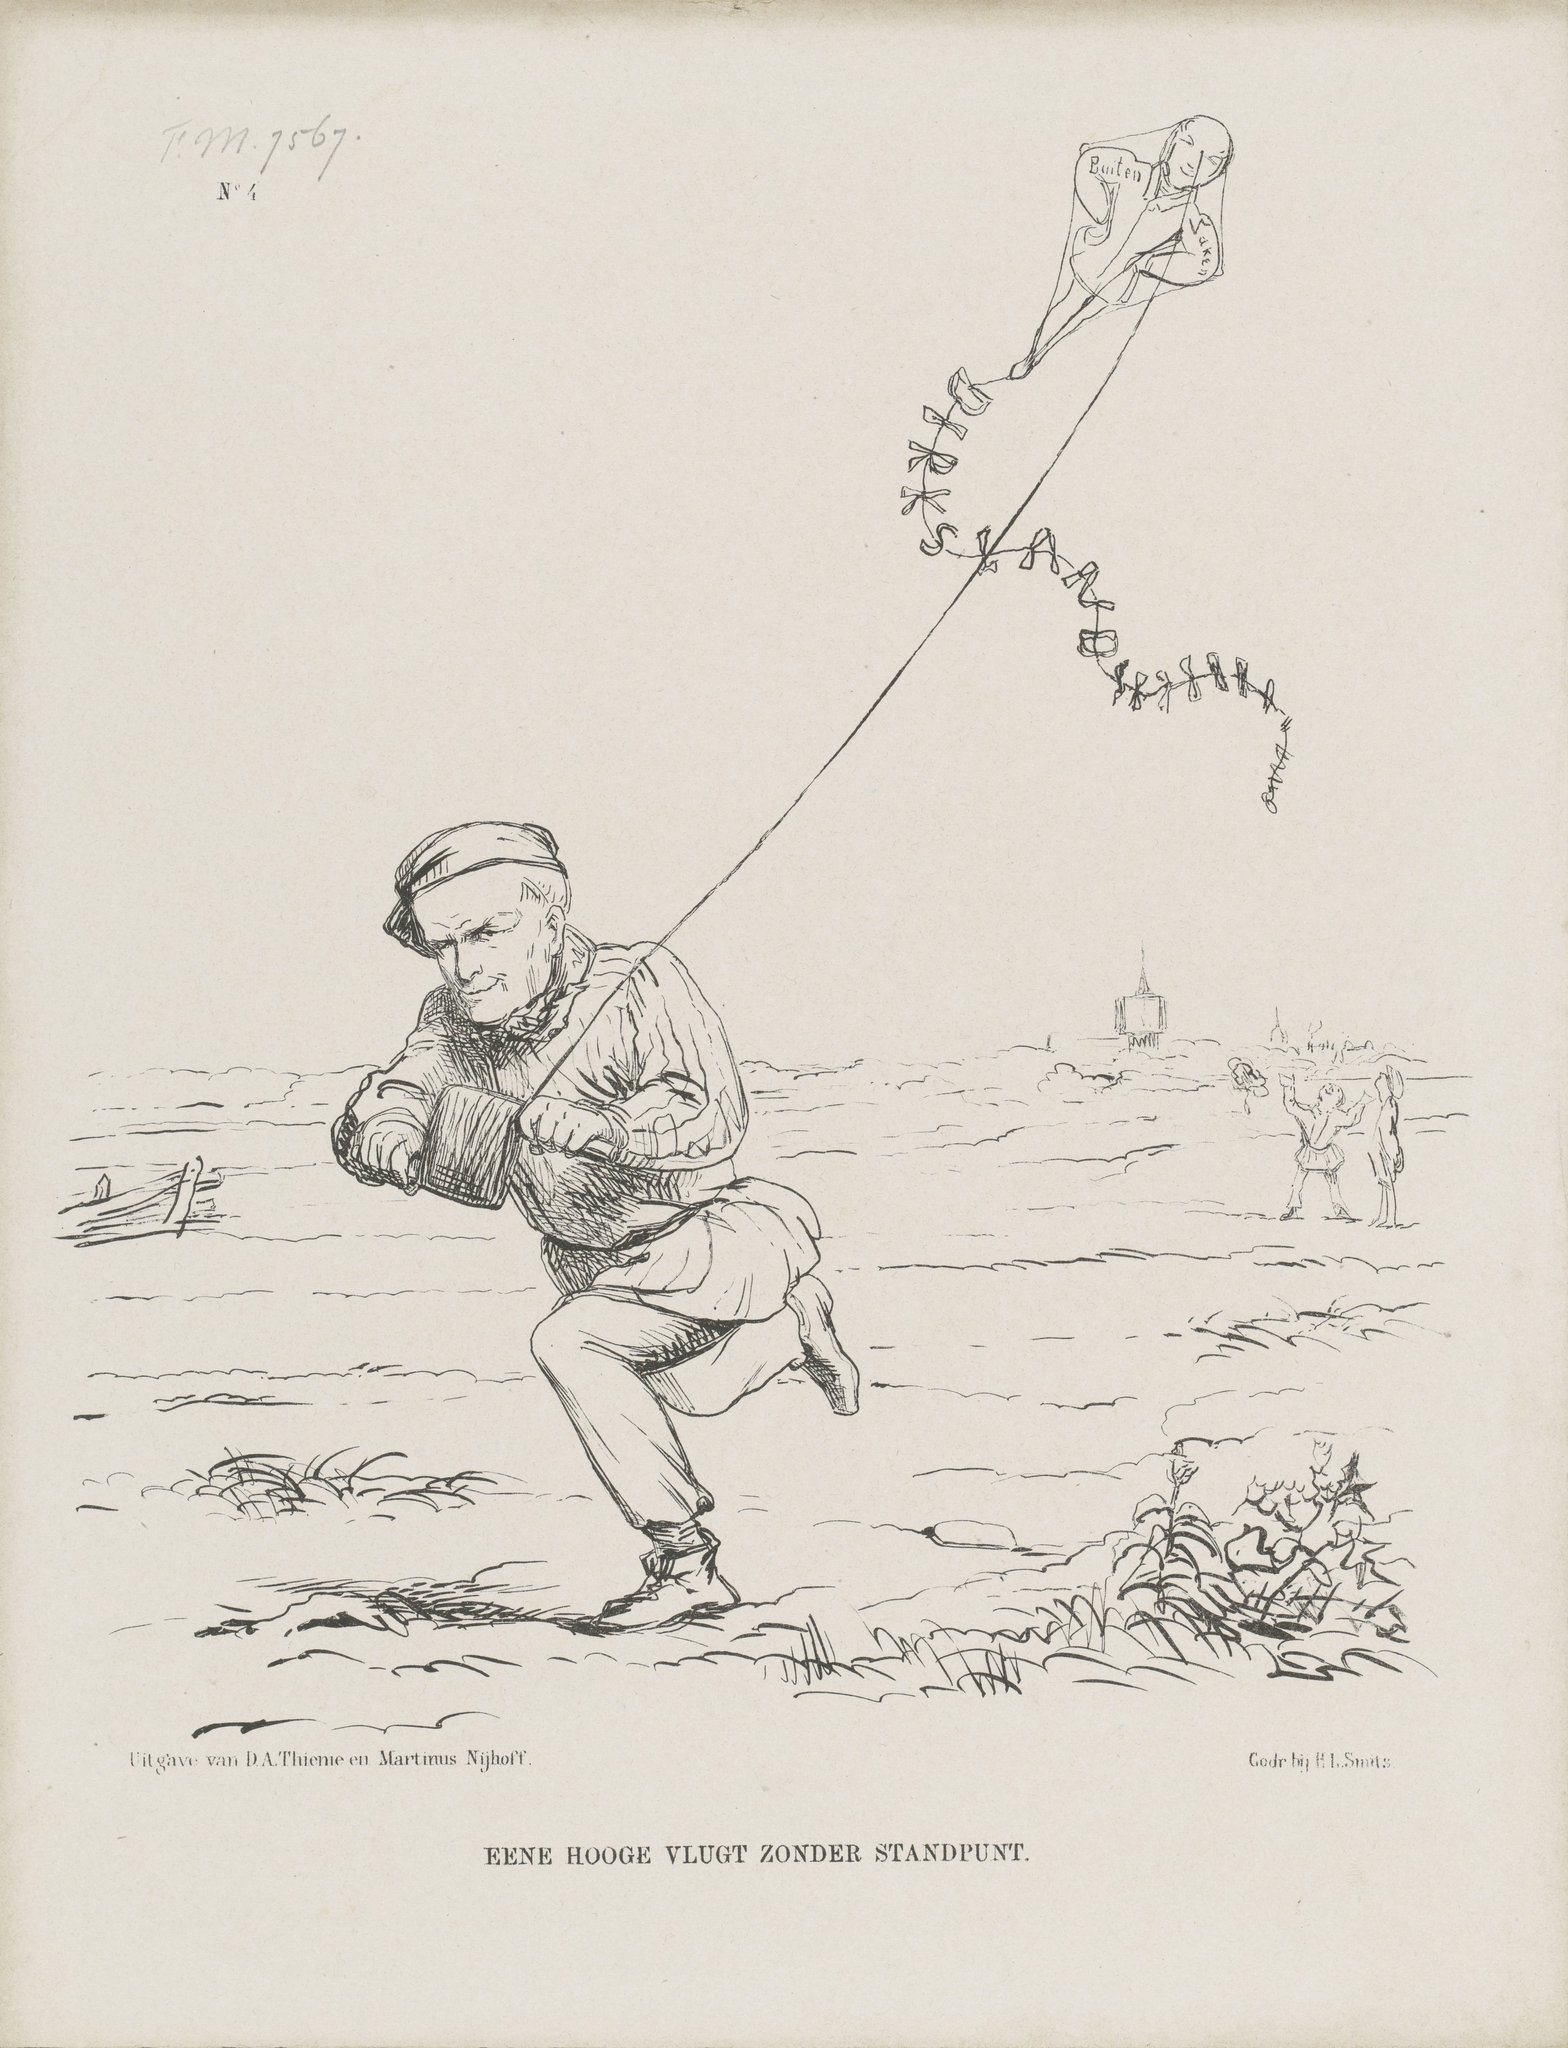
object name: cartoon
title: Eene hooge vlucht zonder standpunt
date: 1861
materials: paper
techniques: lithograph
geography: arnhem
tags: amsterdam, the hague, floris adriaan van hall, (flying a) kite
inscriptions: collector's mark: Lugt 2228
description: Spotprent op minister F.A. van Hall die een vlieger 'Buitenlandse Zaken' in de vorm van Louis Napoleon van der Goes van Dirxland probeert op te laten. Plaat verschenen bij het weekblad De Nederlandsche Spectator, nr. 4, 26 januari 1861.